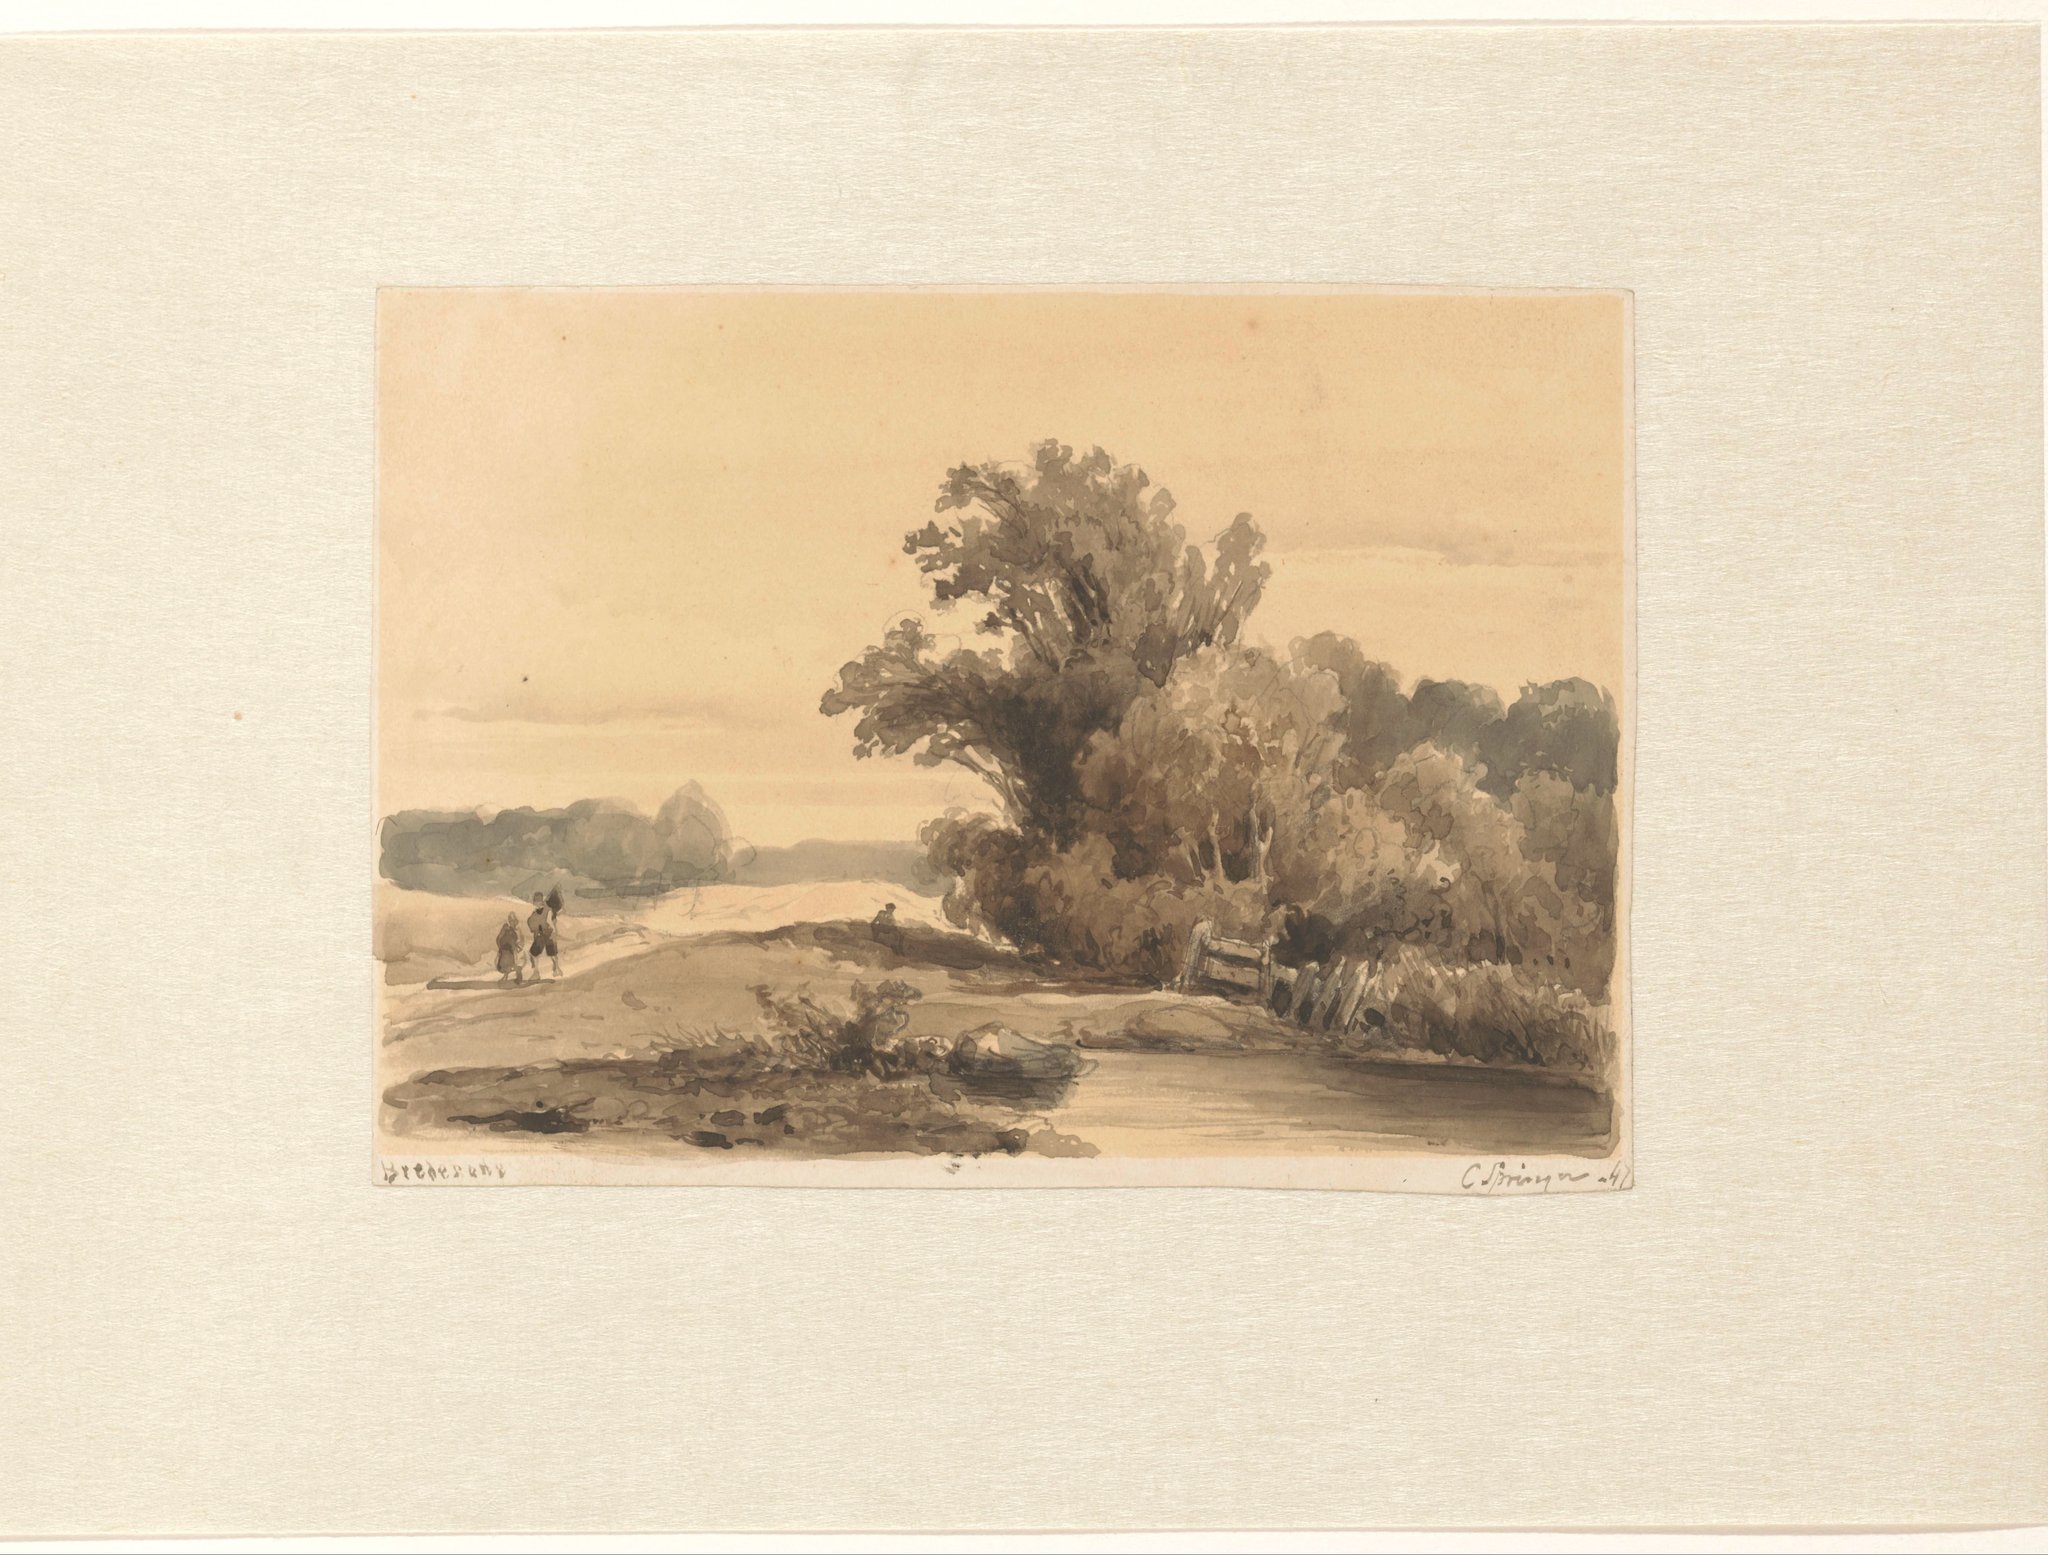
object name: drawing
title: Landschap bij Brederode met wandelaars op een pad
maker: cornelis springer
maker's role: draughtsman, painter, print maker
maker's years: 1817-1891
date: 1847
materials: paper, pencil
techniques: brush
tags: trees, small canal, ditch